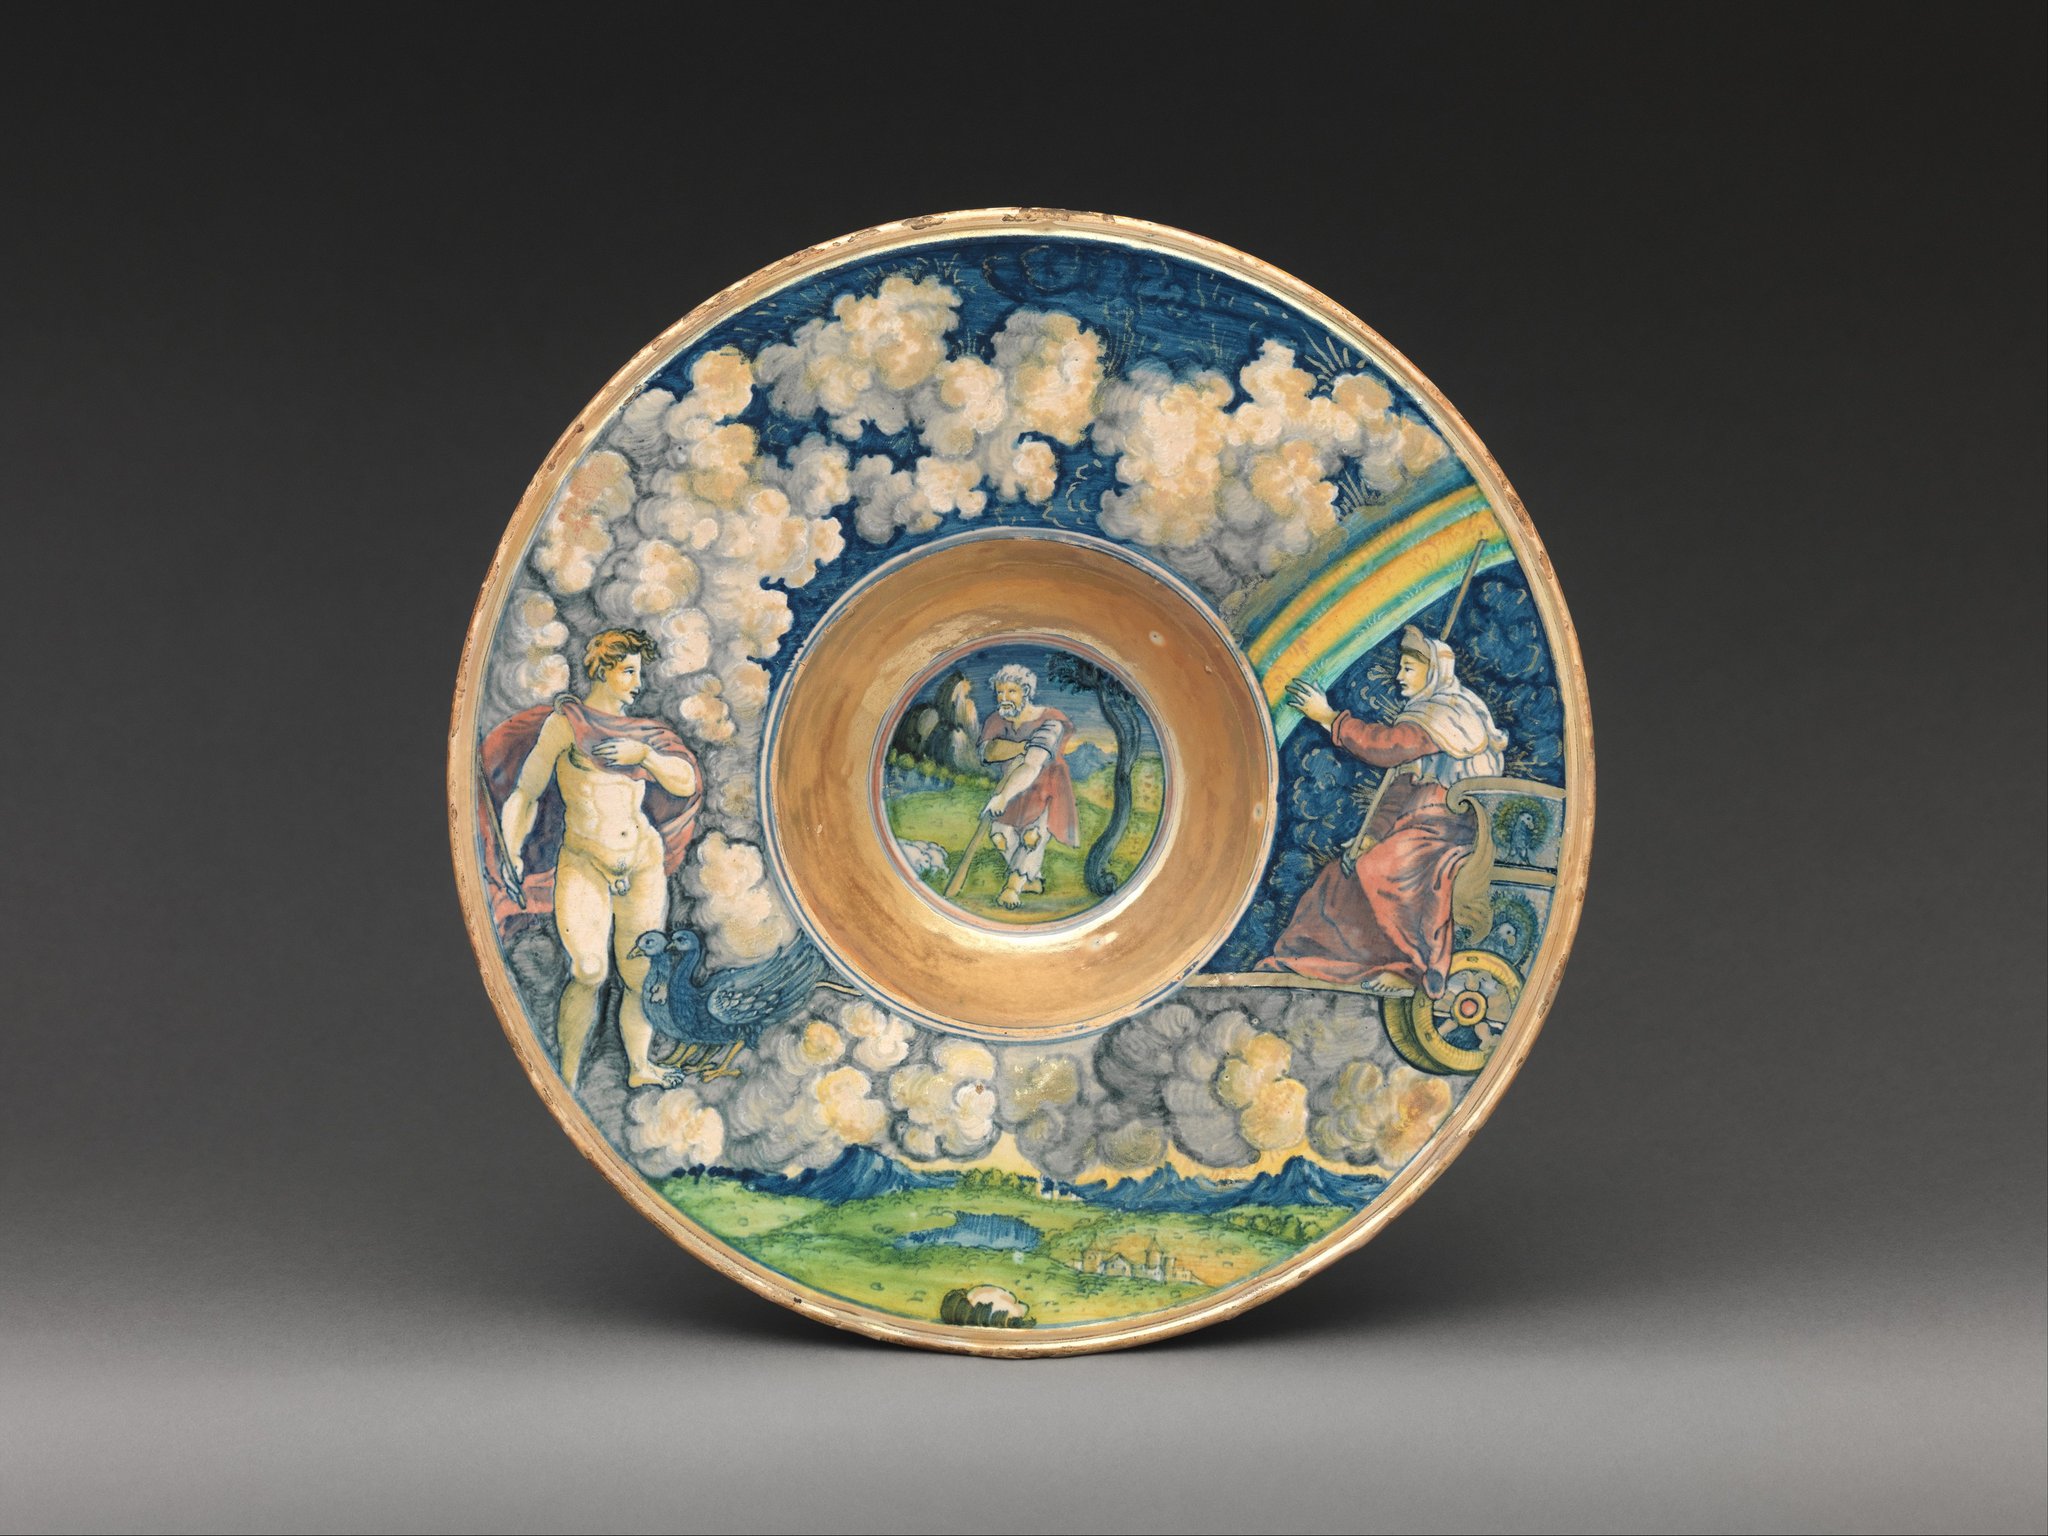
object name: bowl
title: Wide-rimmed bowl with figures from Virgil's Aeneid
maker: maestro giorgio andreoli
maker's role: artist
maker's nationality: italian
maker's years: 1500-1550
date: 1525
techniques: maiolica, glazing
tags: birds,male nudes,women,clouds,chariots,rainbows